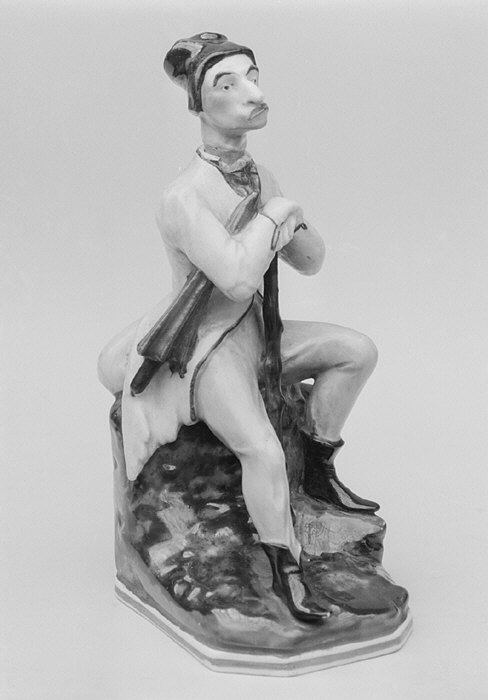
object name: bottle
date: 1834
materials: hard paste porcelain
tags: men